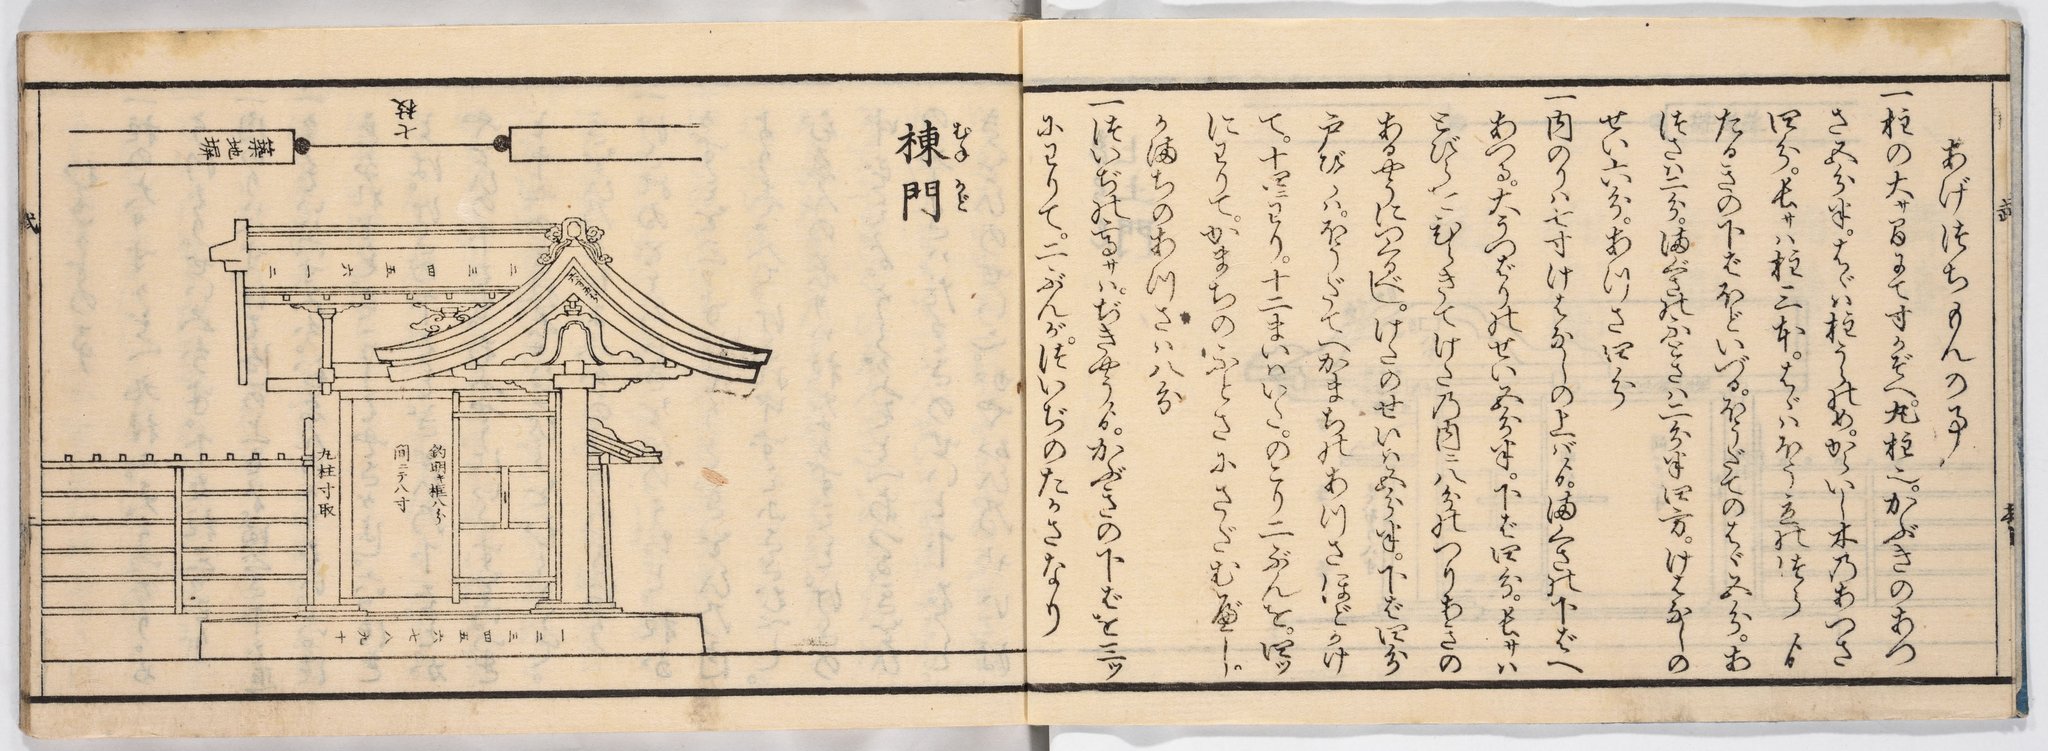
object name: illustrated book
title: New Illustrated Manual of Warrior Architecture, 2 (Shinpan/Buke hinagata, ni)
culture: japanese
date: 1893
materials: ink, paper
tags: architecture